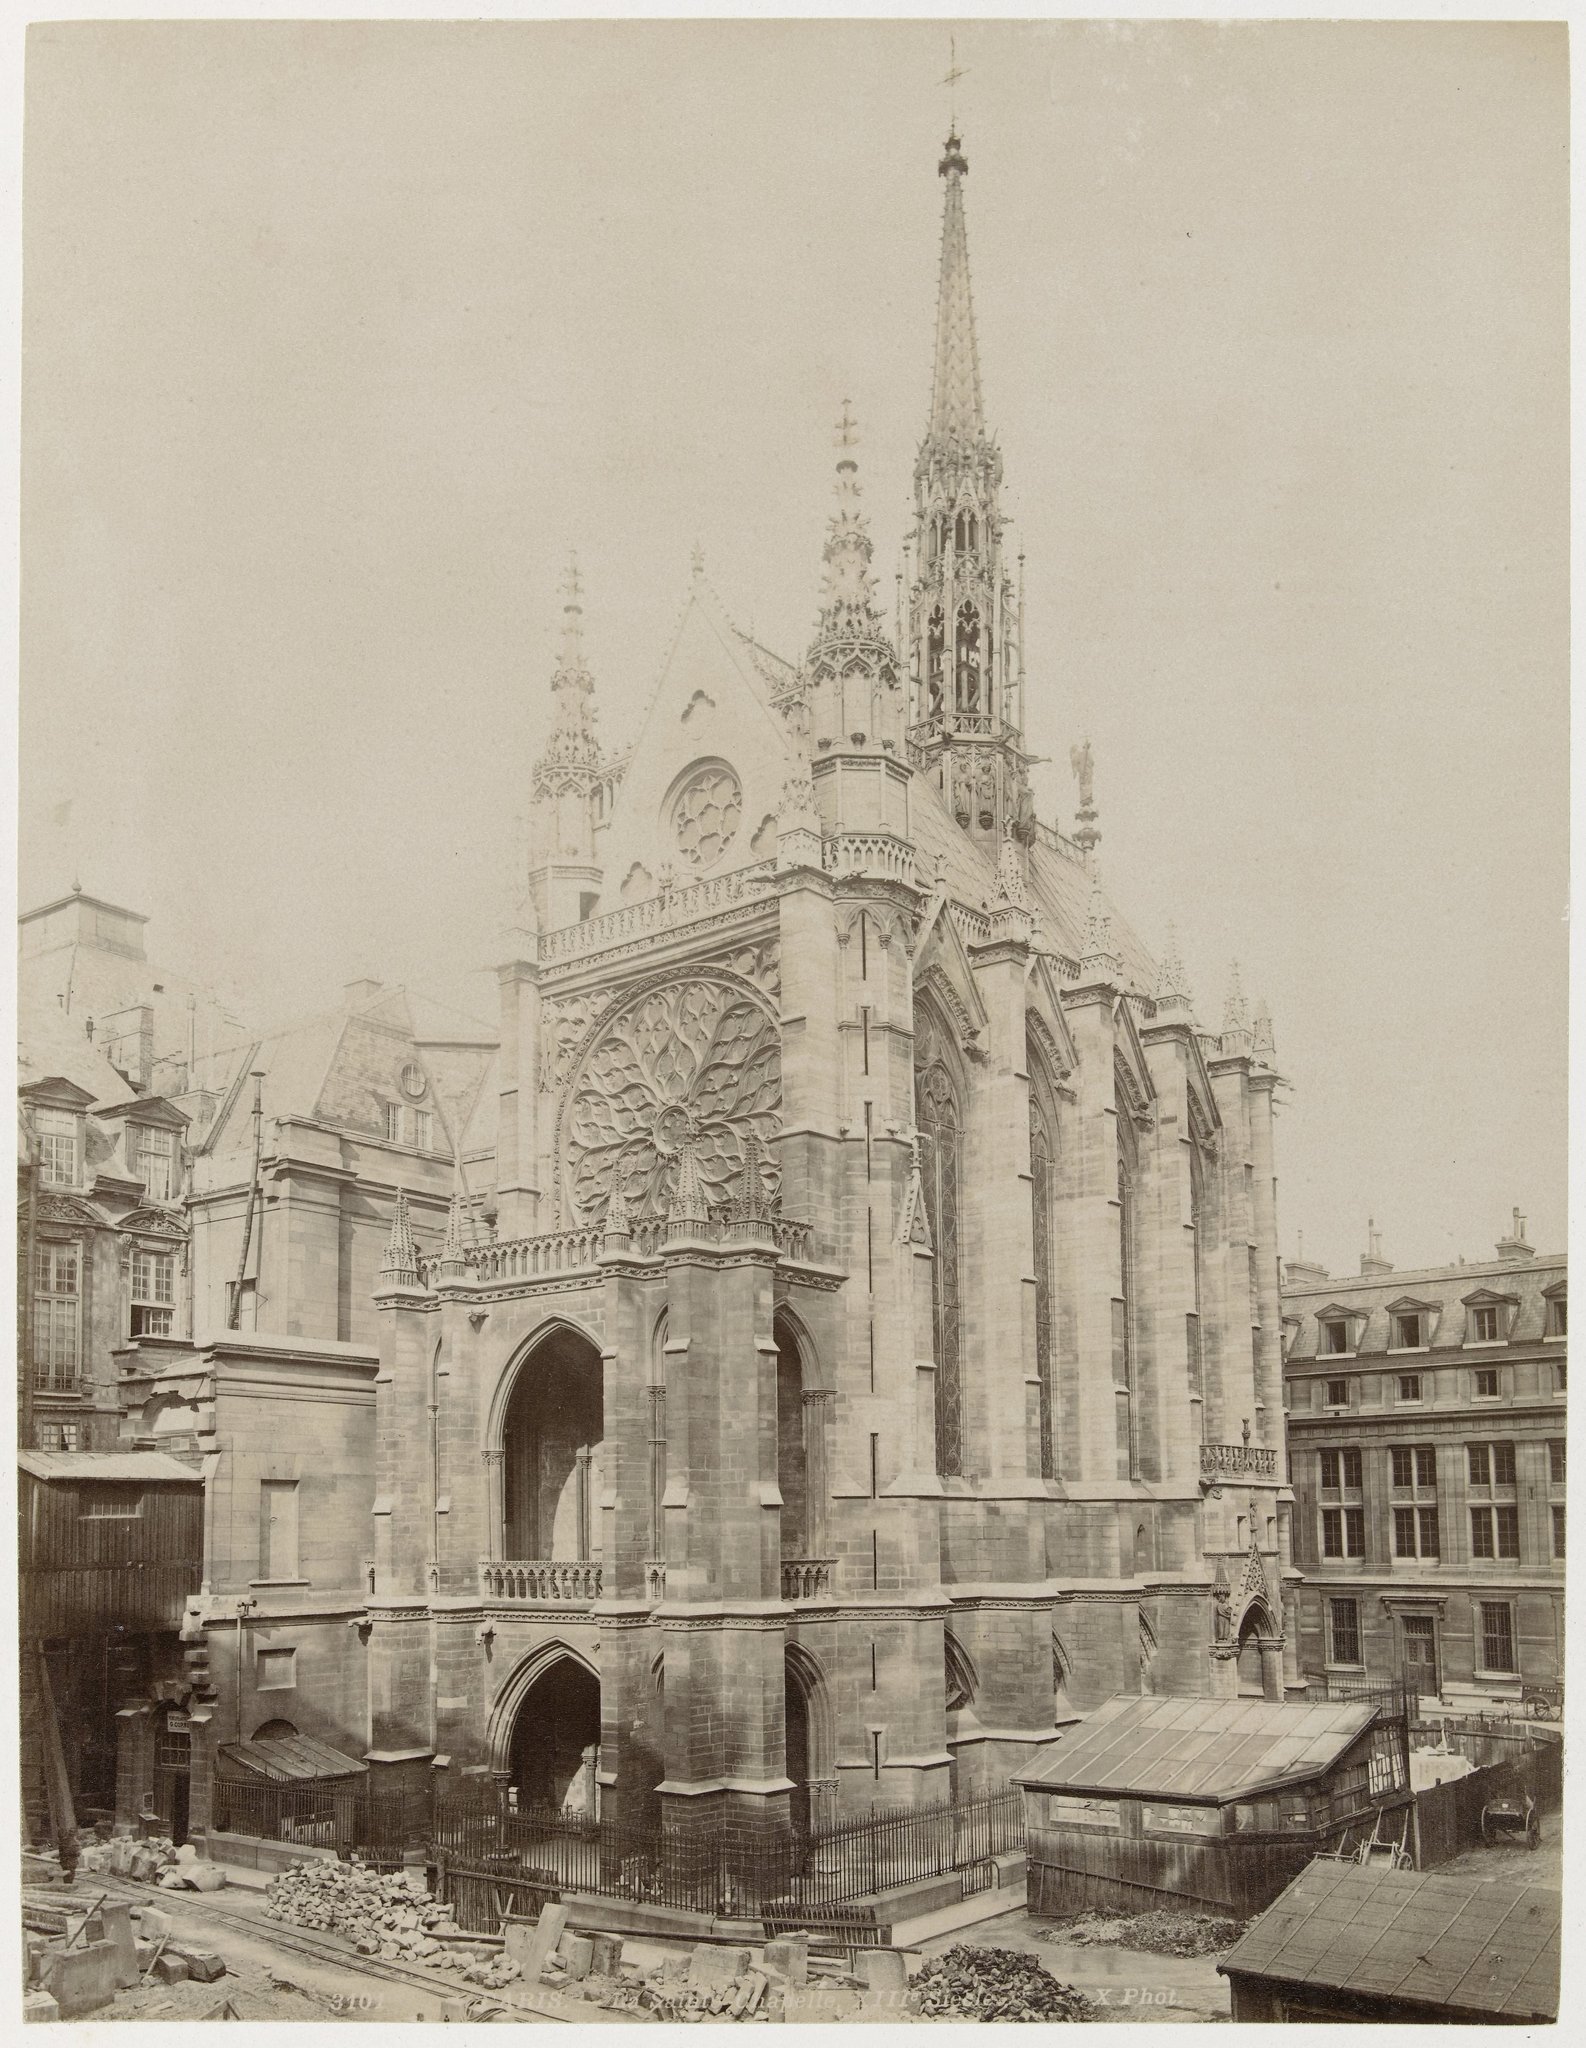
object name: photograph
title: Paris. - La Sainte-Chapelle. XIIIe Siècle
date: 1841-1867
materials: cardboard, paper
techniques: albumen print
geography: paris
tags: church (exterior), building-site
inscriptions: inscription: ‘3101 Paris. - La Sainte-Chapelle. XIIIe Siècle. X. Phot.’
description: Tussen 1887 en ca. 1900 werkten Neurdein frères onder andere onder de naam 'X phot.'.